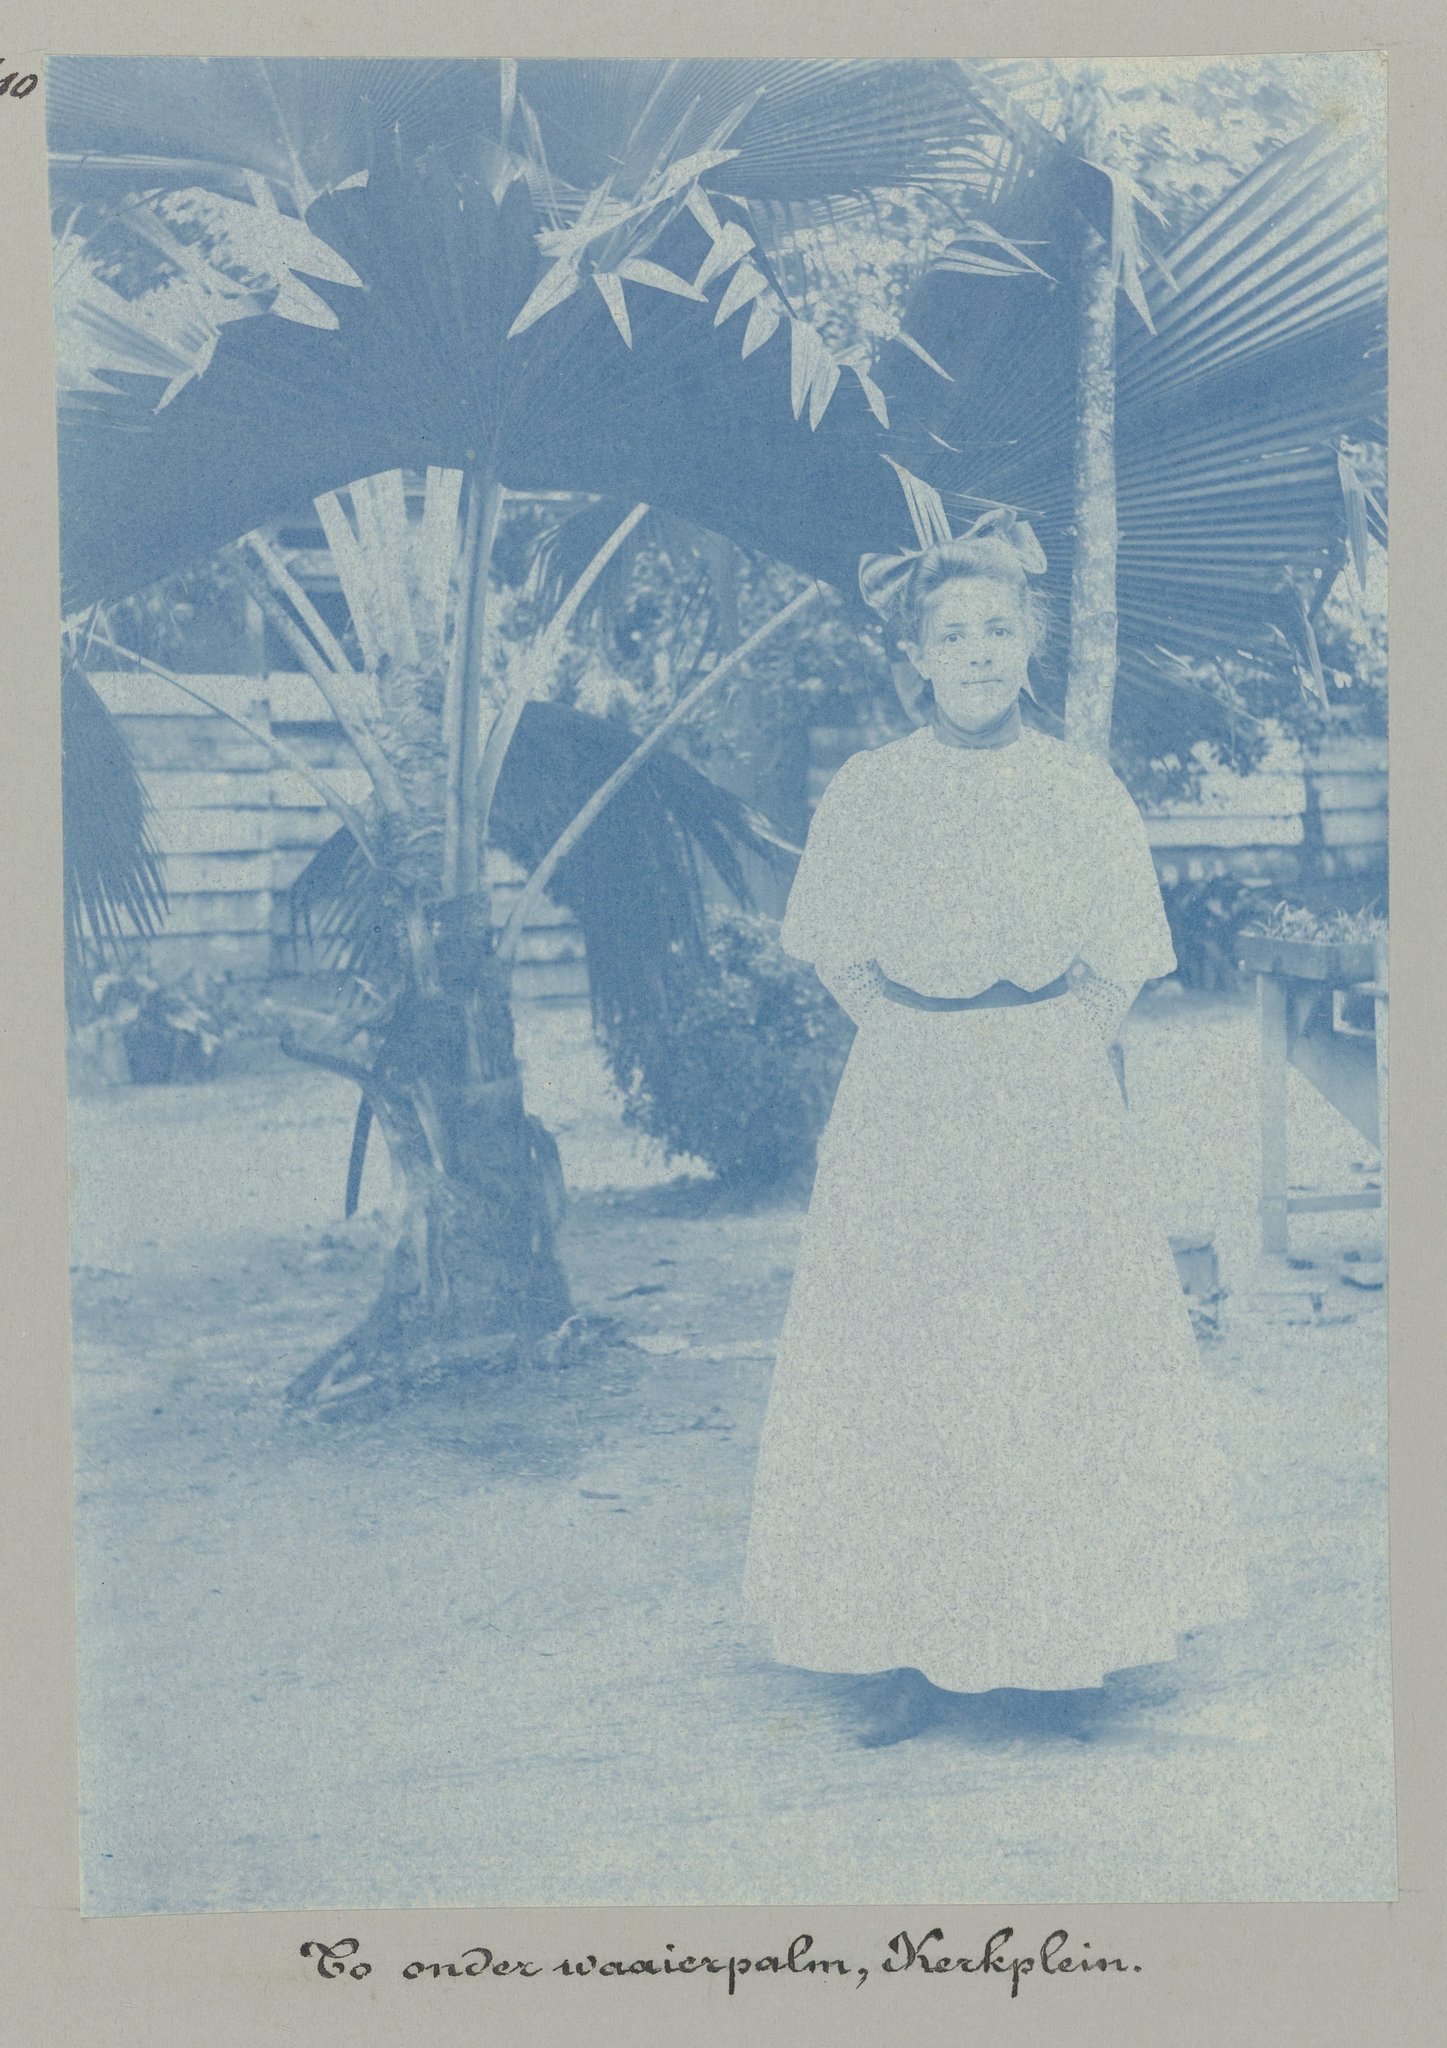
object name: photograph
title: To onder waaierpalm, Kerkplein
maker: hendrik doijer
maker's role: engineer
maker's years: 1863-1925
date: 1903-1910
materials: photographic support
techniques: cyanotype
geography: suriname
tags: suriname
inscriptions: inscription: ‘E10 / To onder waaierpalm, Kerkplein.’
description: Jonge Nederlandse vrouw genaamd To, staande onder een waaierpalm op het Kerkplein te Paramaribo. Onderdeel van het fotoalbum Souvenir de Voyage (deel 4), over het leven van de familie Doijer in en rond de plantage Ma Retraite in Suriname in de jaren 1903-1910.